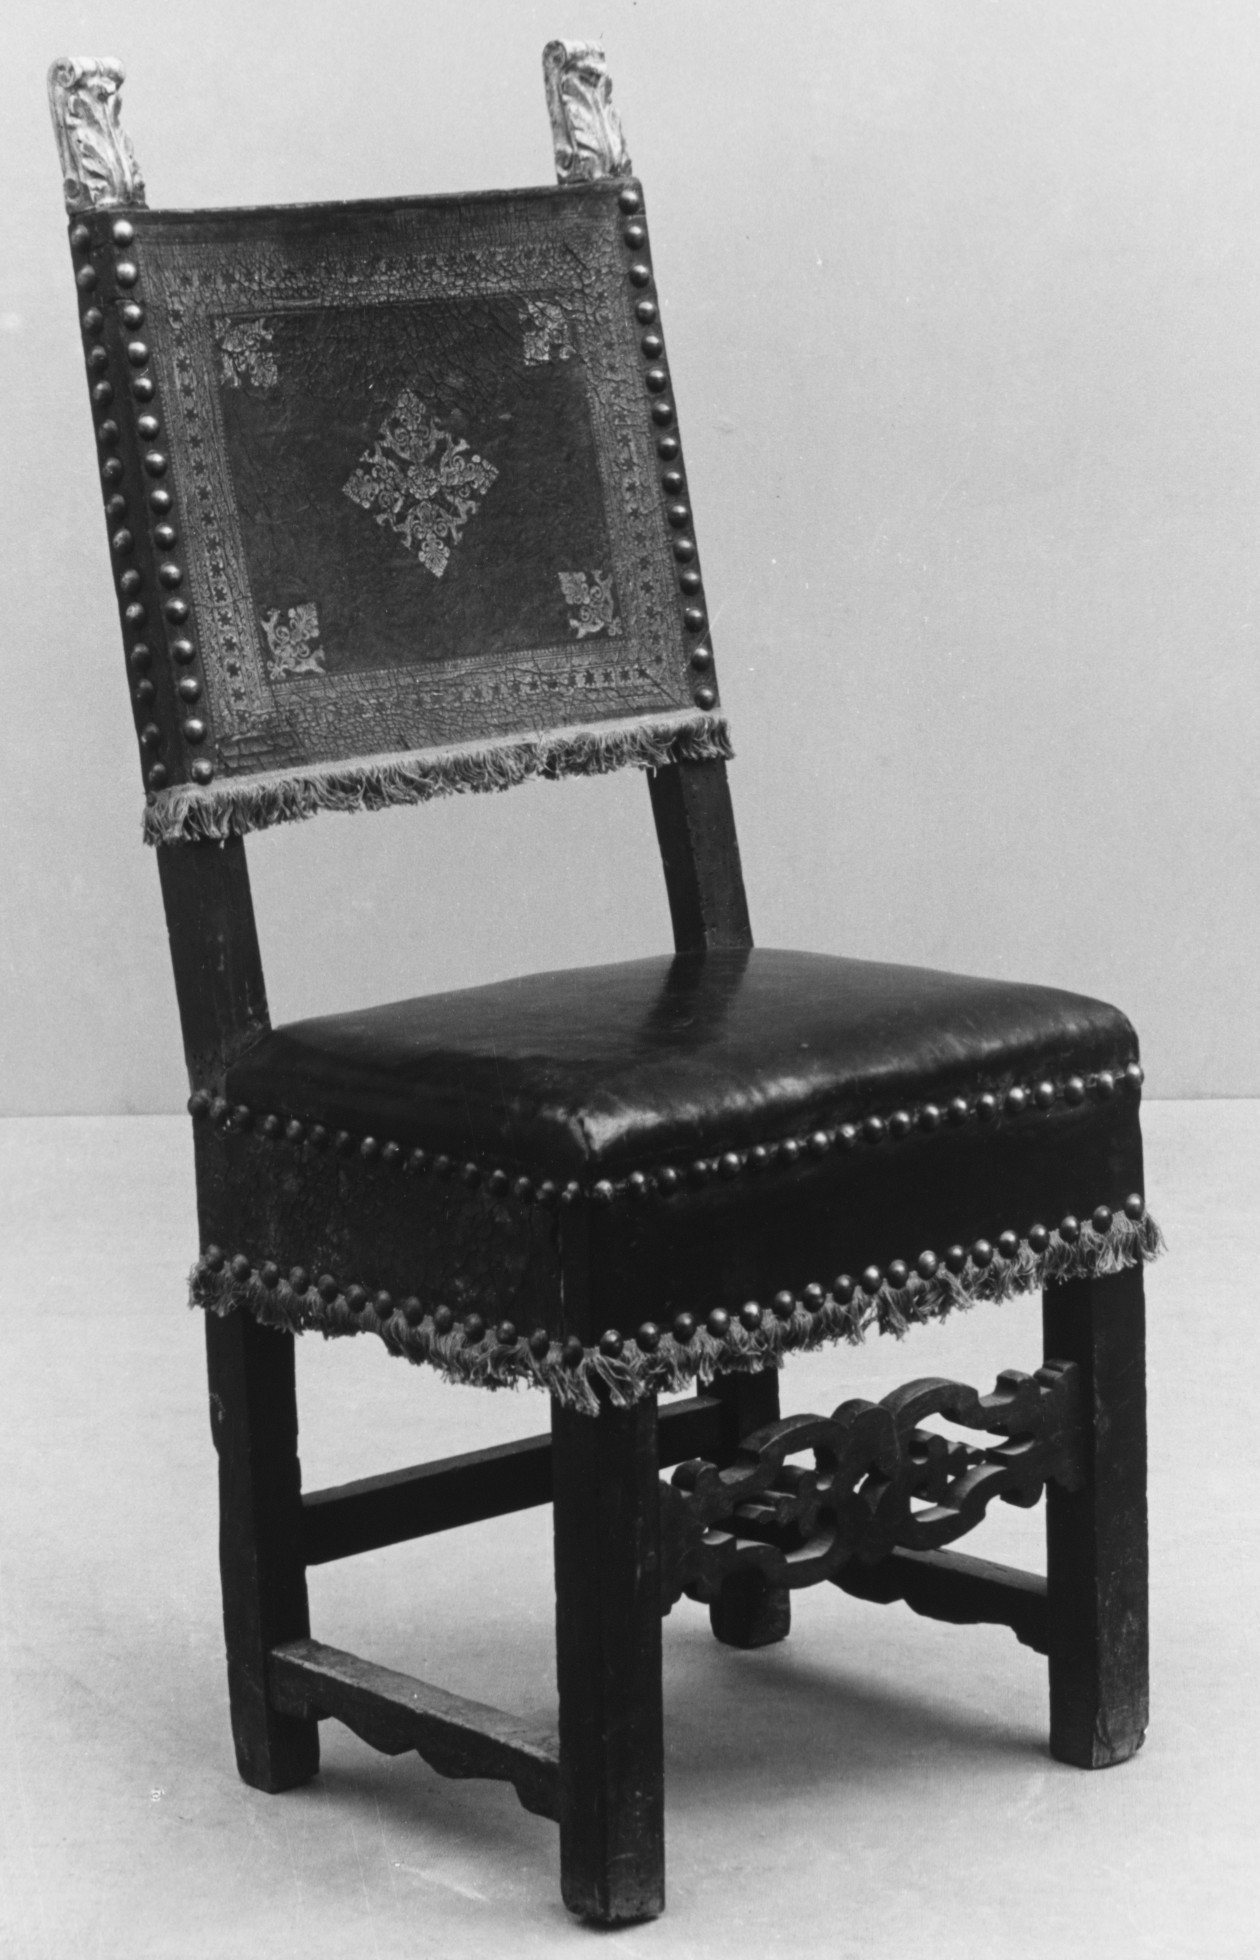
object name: side chair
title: Pair of side chairs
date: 1567-1600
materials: leather, wood